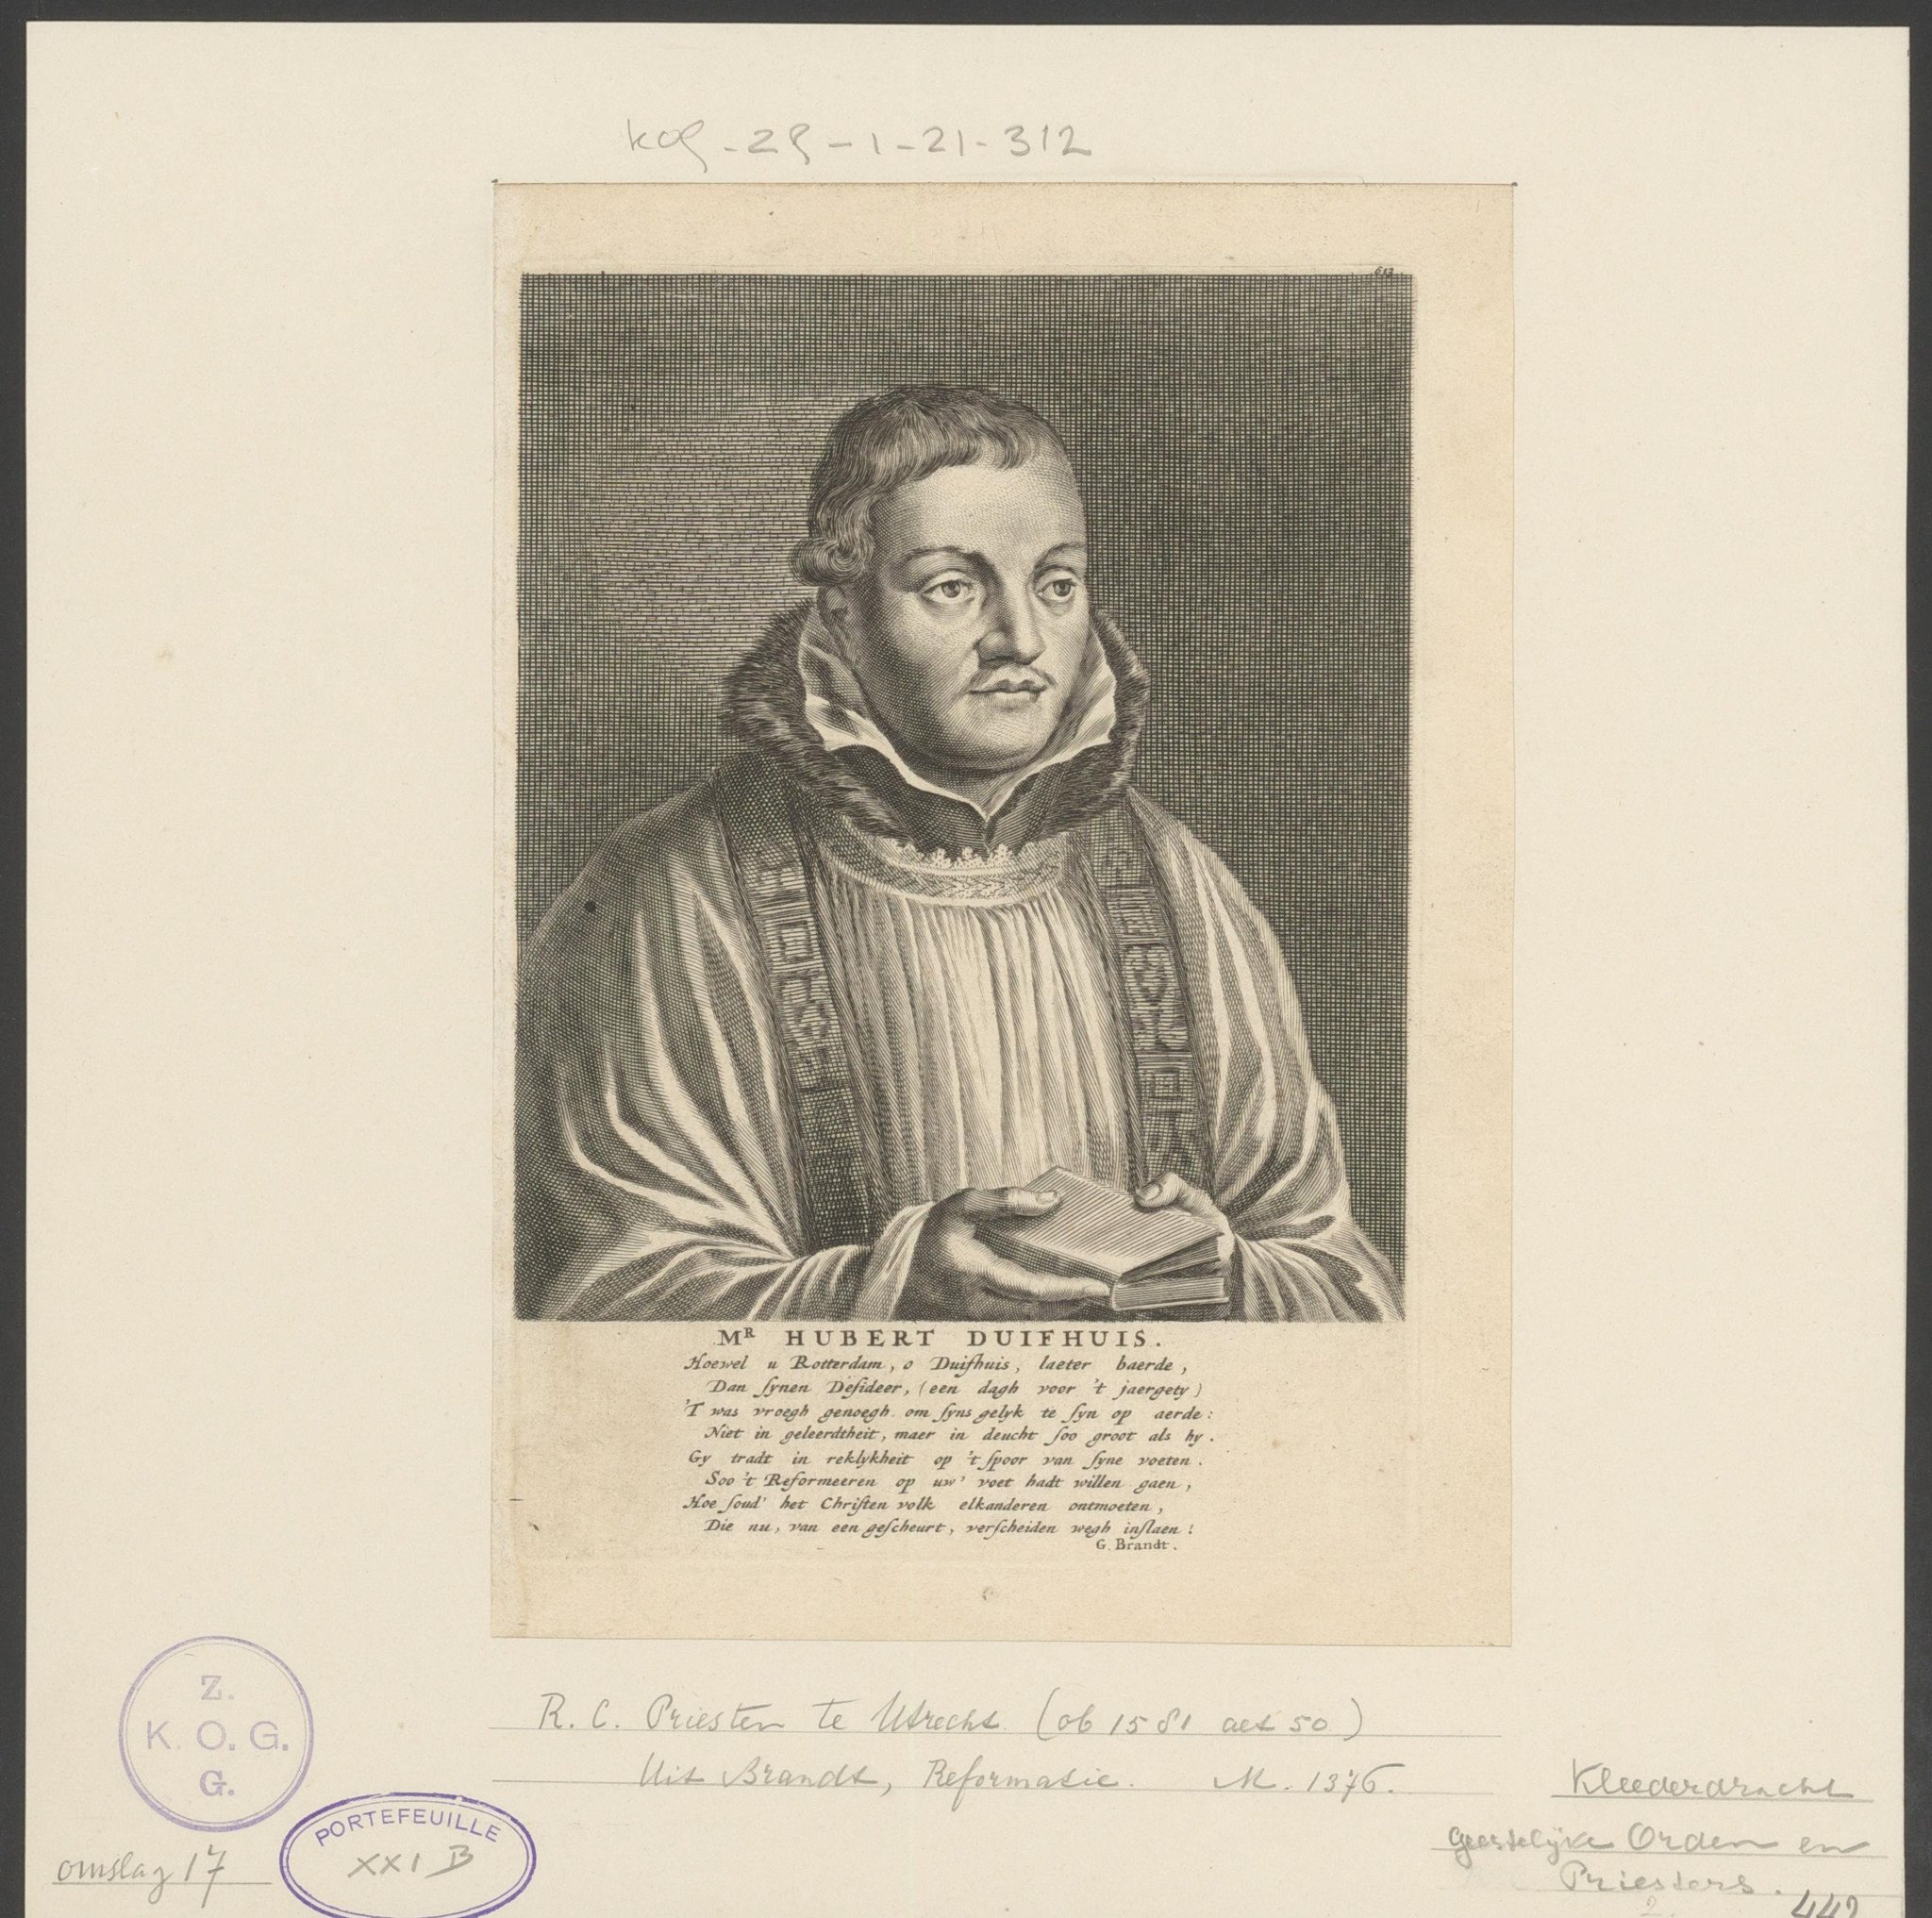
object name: print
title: Portret van Huibert Duifhuis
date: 1671-1677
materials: paper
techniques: engraving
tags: historical persons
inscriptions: collector's mark: Lugt 1641, stamp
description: Prent ook gebruikt in: G. Brandts Historie der Reformatie, en andre kerkelyke geschiedenissen, in en ontrent de Nederlanden. Met eenige aantekeningen en aenmerkingen, Naerder oversien, merkelijk vermeerdert, en vervolgt tot het jaer 1600 [Het eerste deel]. 1e druk. Amsterdam: Jan Rieuwertsz. I en Hendrik en Dirk Boom, 1671, tussen p. 612 en 613. En in: G. Brandts Historie der Reformatie, en andre kerkelyke geschiedenissen, in en ontrent de Nederlanden. Met eenige aantekeningen en aenmerkingen, Naerder oversien, merkelijk vermeerdert, en vervolgt tot het jaer 1600 [Het eerste deel]. 2e druk. Amsterdam: Jan Rieuwertsz. I en Hendrik en Dirk Boom, 1677,* tussen p. 612 en 613. * Van de tweede druk van het eerste deel bestaat een andere versie met exact dezelfde titel, uitgevers en jaartal. Deze versie is typografisch echter anders en bevat andere prenten. Alle prenten in die publicatie zijn van de hand van Jan Lamsvelt (werkzame periode: 1696-1743), waardoor het geheel in of na 1696 te dateren valt.